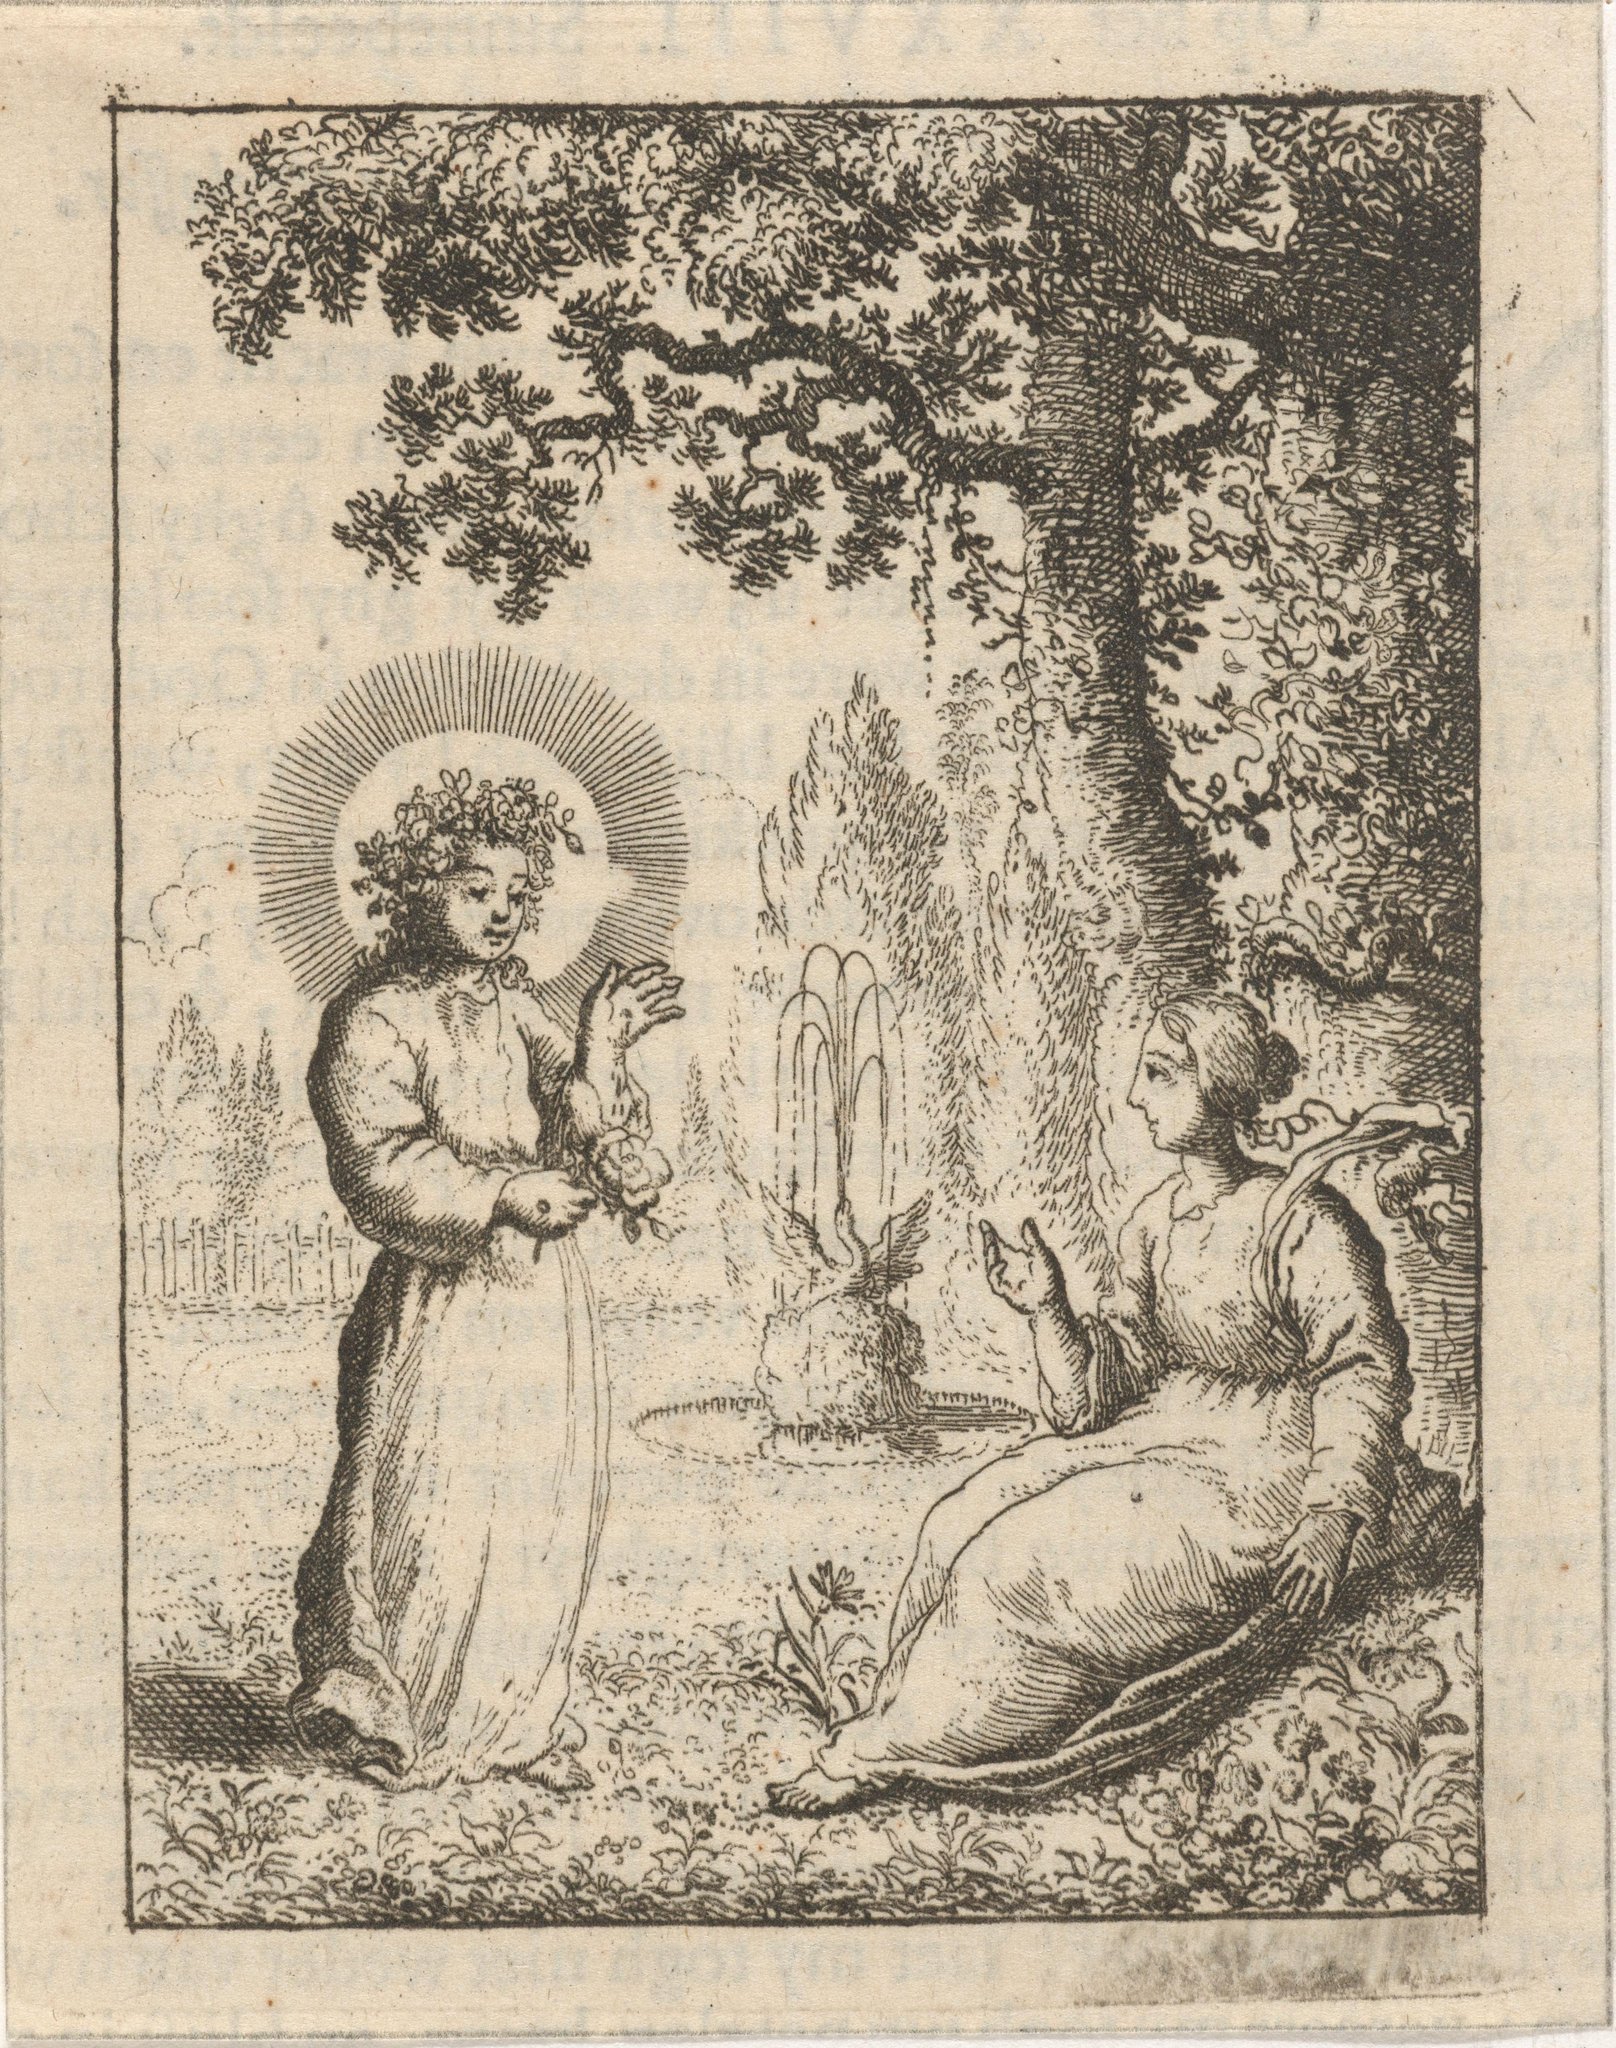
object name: book illustration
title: Christus en de gepersonifieerde ziel bij een fontein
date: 1678-1687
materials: paper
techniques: etching, letterpress printing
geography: amsterdam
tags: garden fountain, christ and the soul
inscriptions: collector's mark: Lugt 2228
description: Illustratie uit: Luyken, Jan. Jezus en de Ziel, 3 delen. Amsterdam: Pieter Arentsz II, 1678-1687. Tussen 1678-1744 verschenen van dit emblemataboek 10 edities.